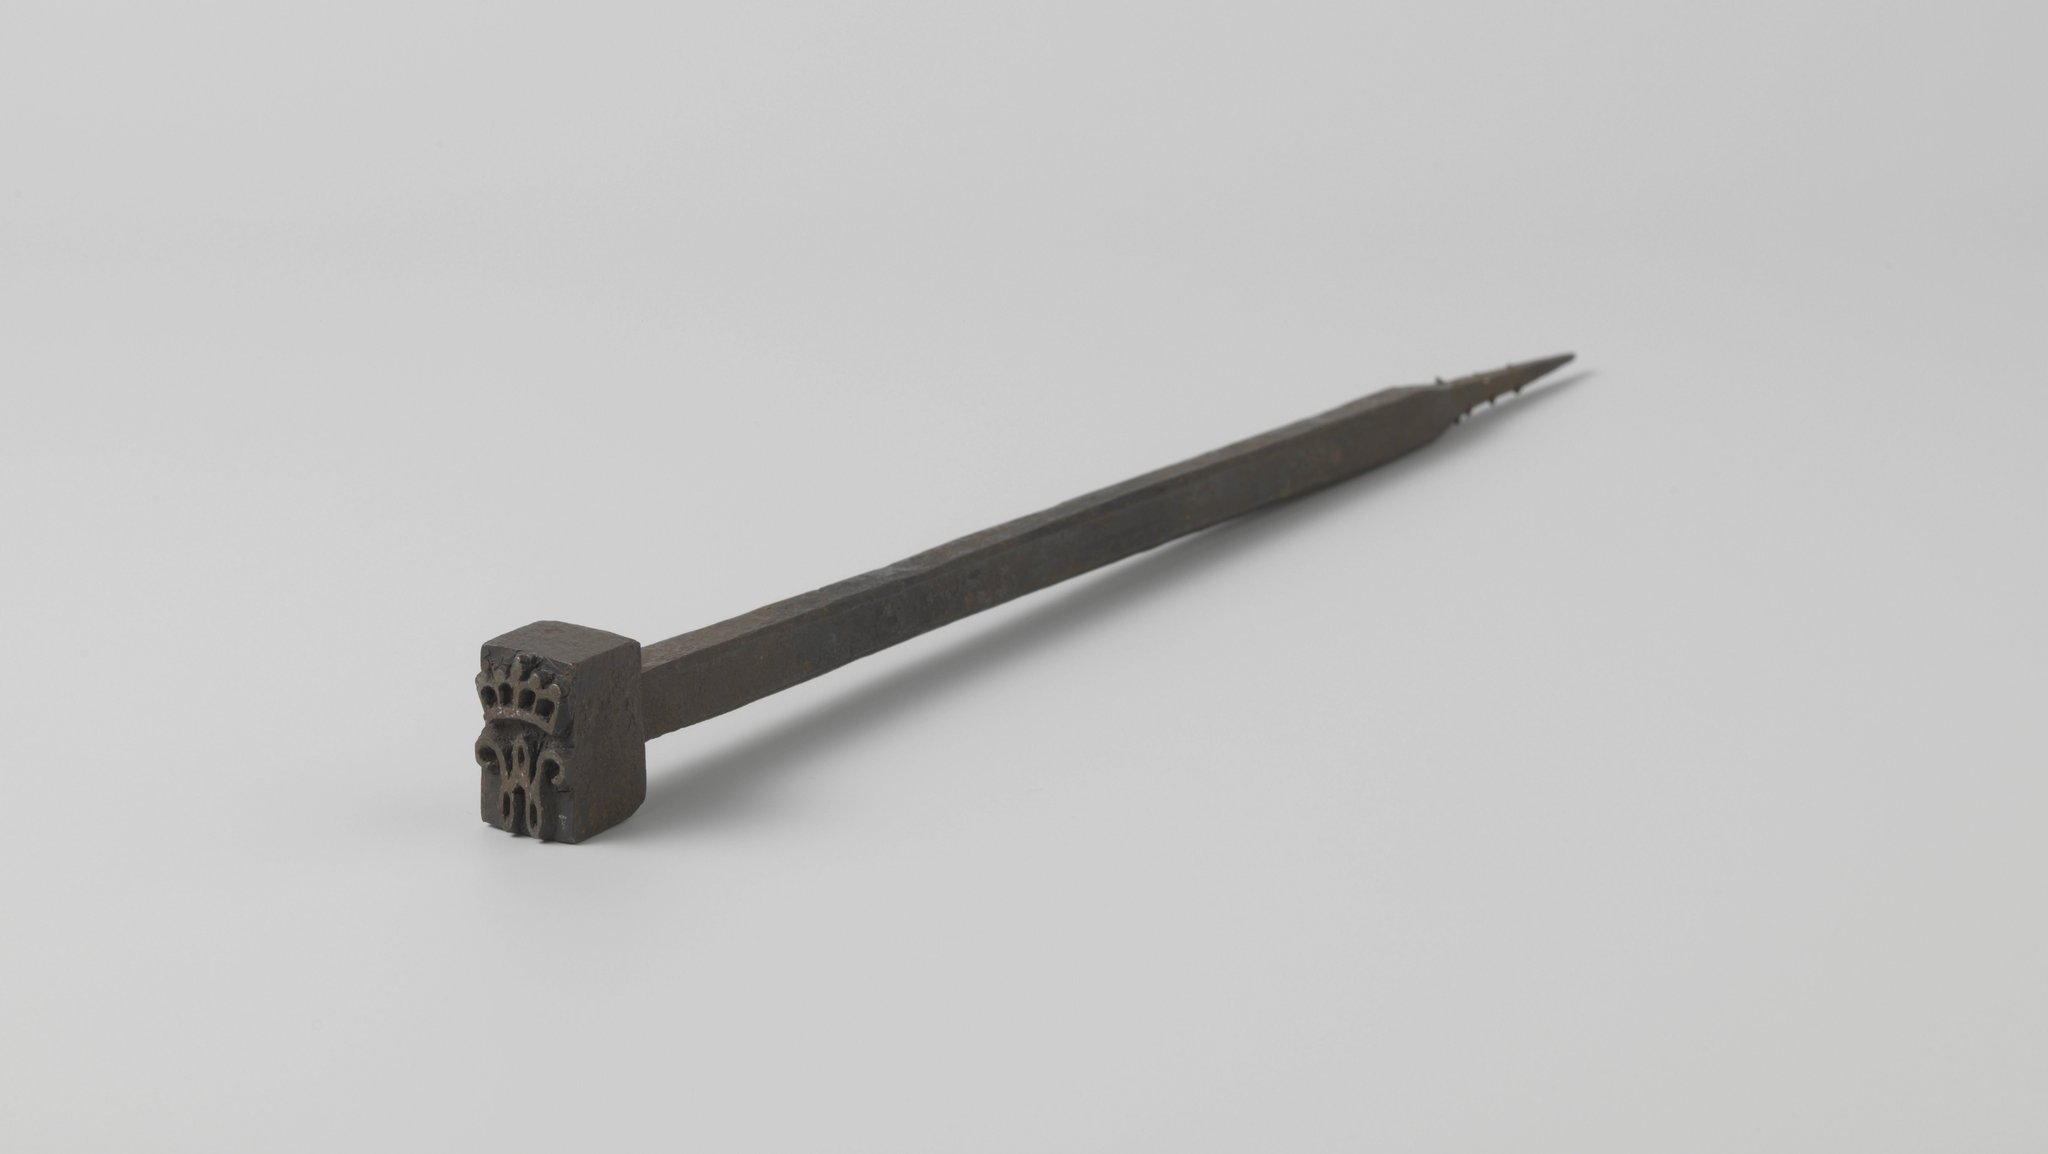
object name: tool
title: Meubelbrandijzer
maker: Anonymous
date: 1849-1890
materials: iron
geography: northern netherlands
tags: willem iii (koning der nederlanden)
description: Meubelbrandijzer van Koning Willem III der Nederlanden (1817-1890). Het blokvormige uiteinde dat aan de voorzijde een gekroonde, lopende W vertoont, gaat over in een lange pin van vierkante doorsnede. Het toegespitste einde heeft weerhaken, waarmee het geheel oorspronkelijk met een thans niet meer aanwezig, waarschijnlijk houten handvat verbonden was.